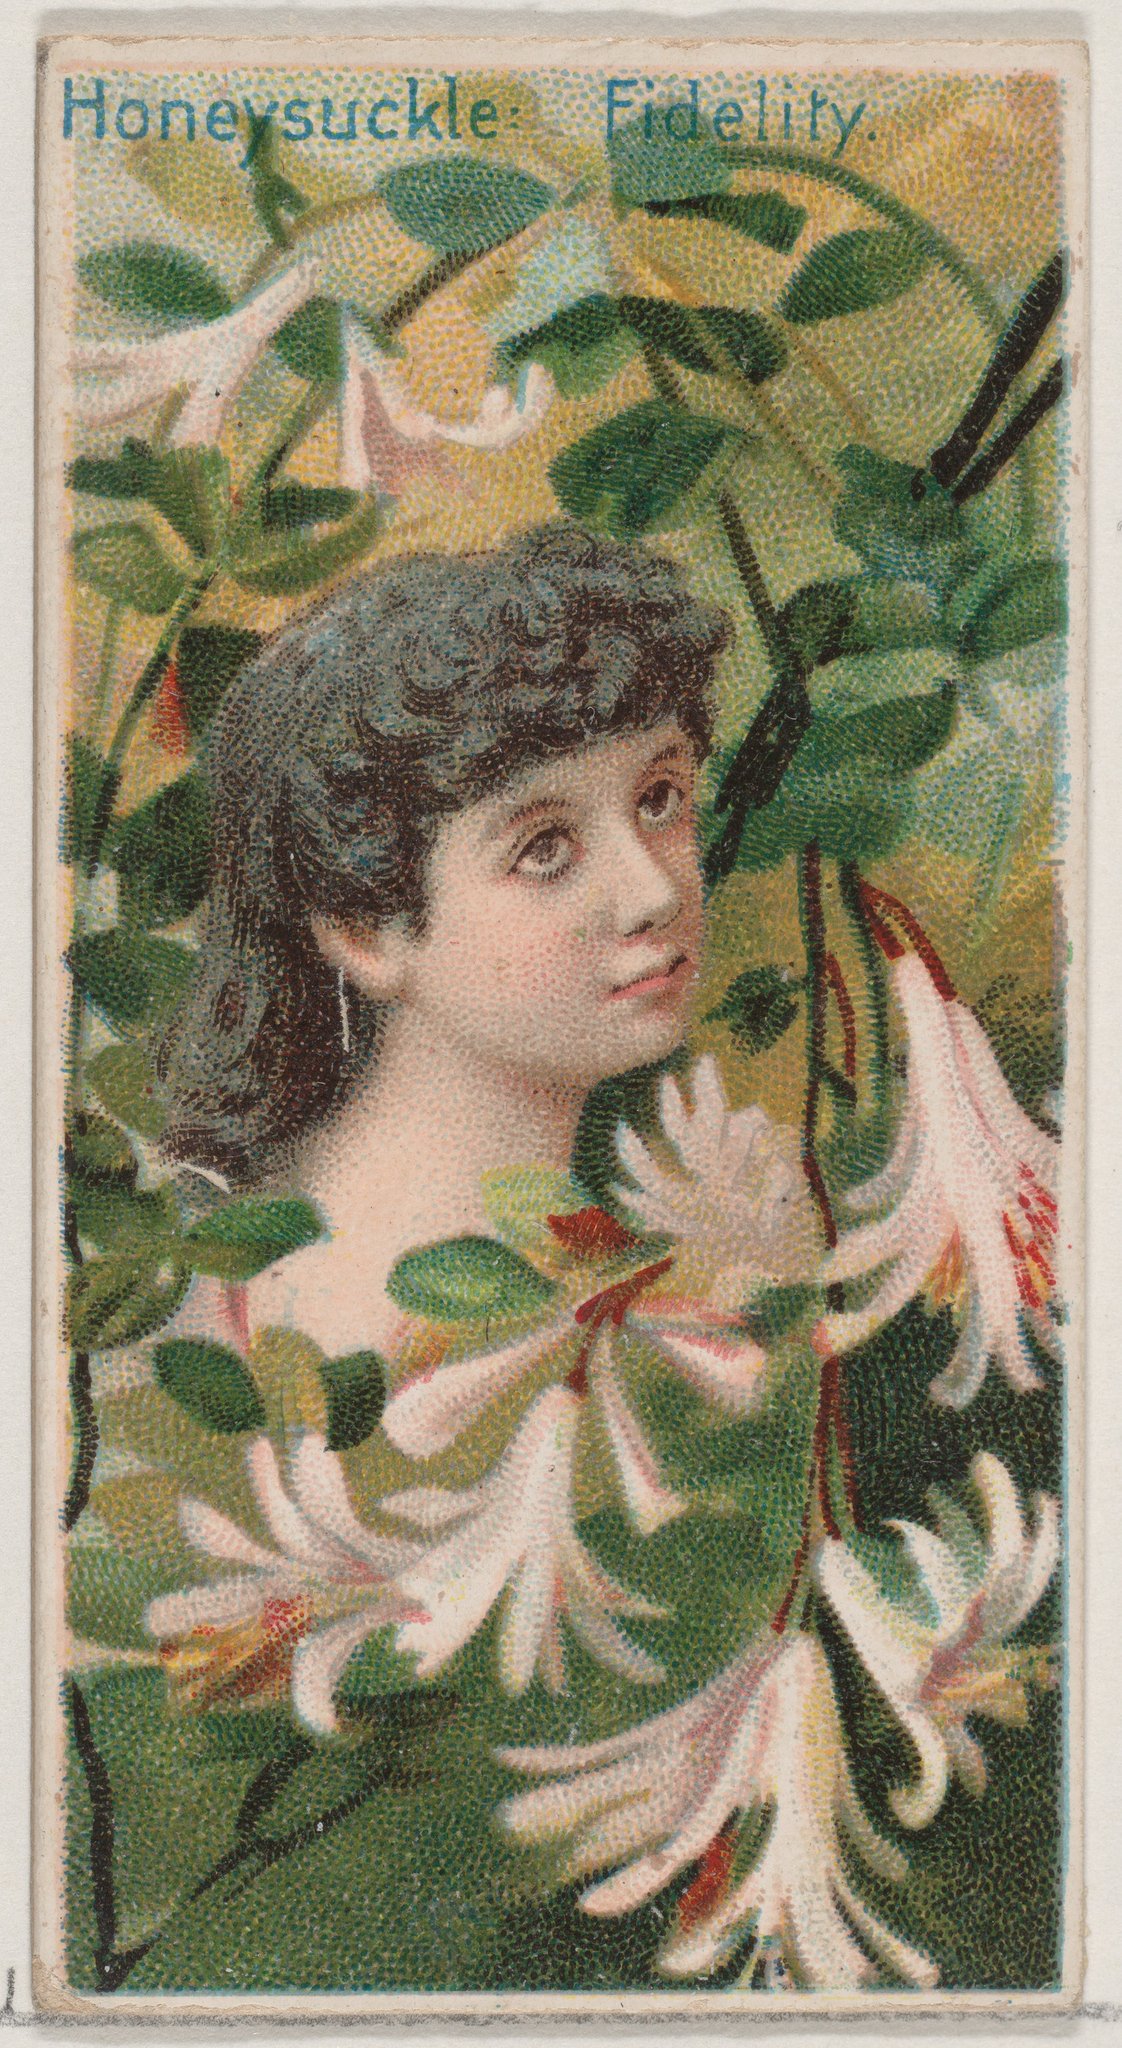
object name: print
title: Honeysuckle: Fidelity, from the series Floral Beauties and Language of Flowers (N75) for Duke brand cigarettes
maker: american tobacco company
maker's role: publisher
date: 1892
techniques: color lithograph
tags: women,flowers